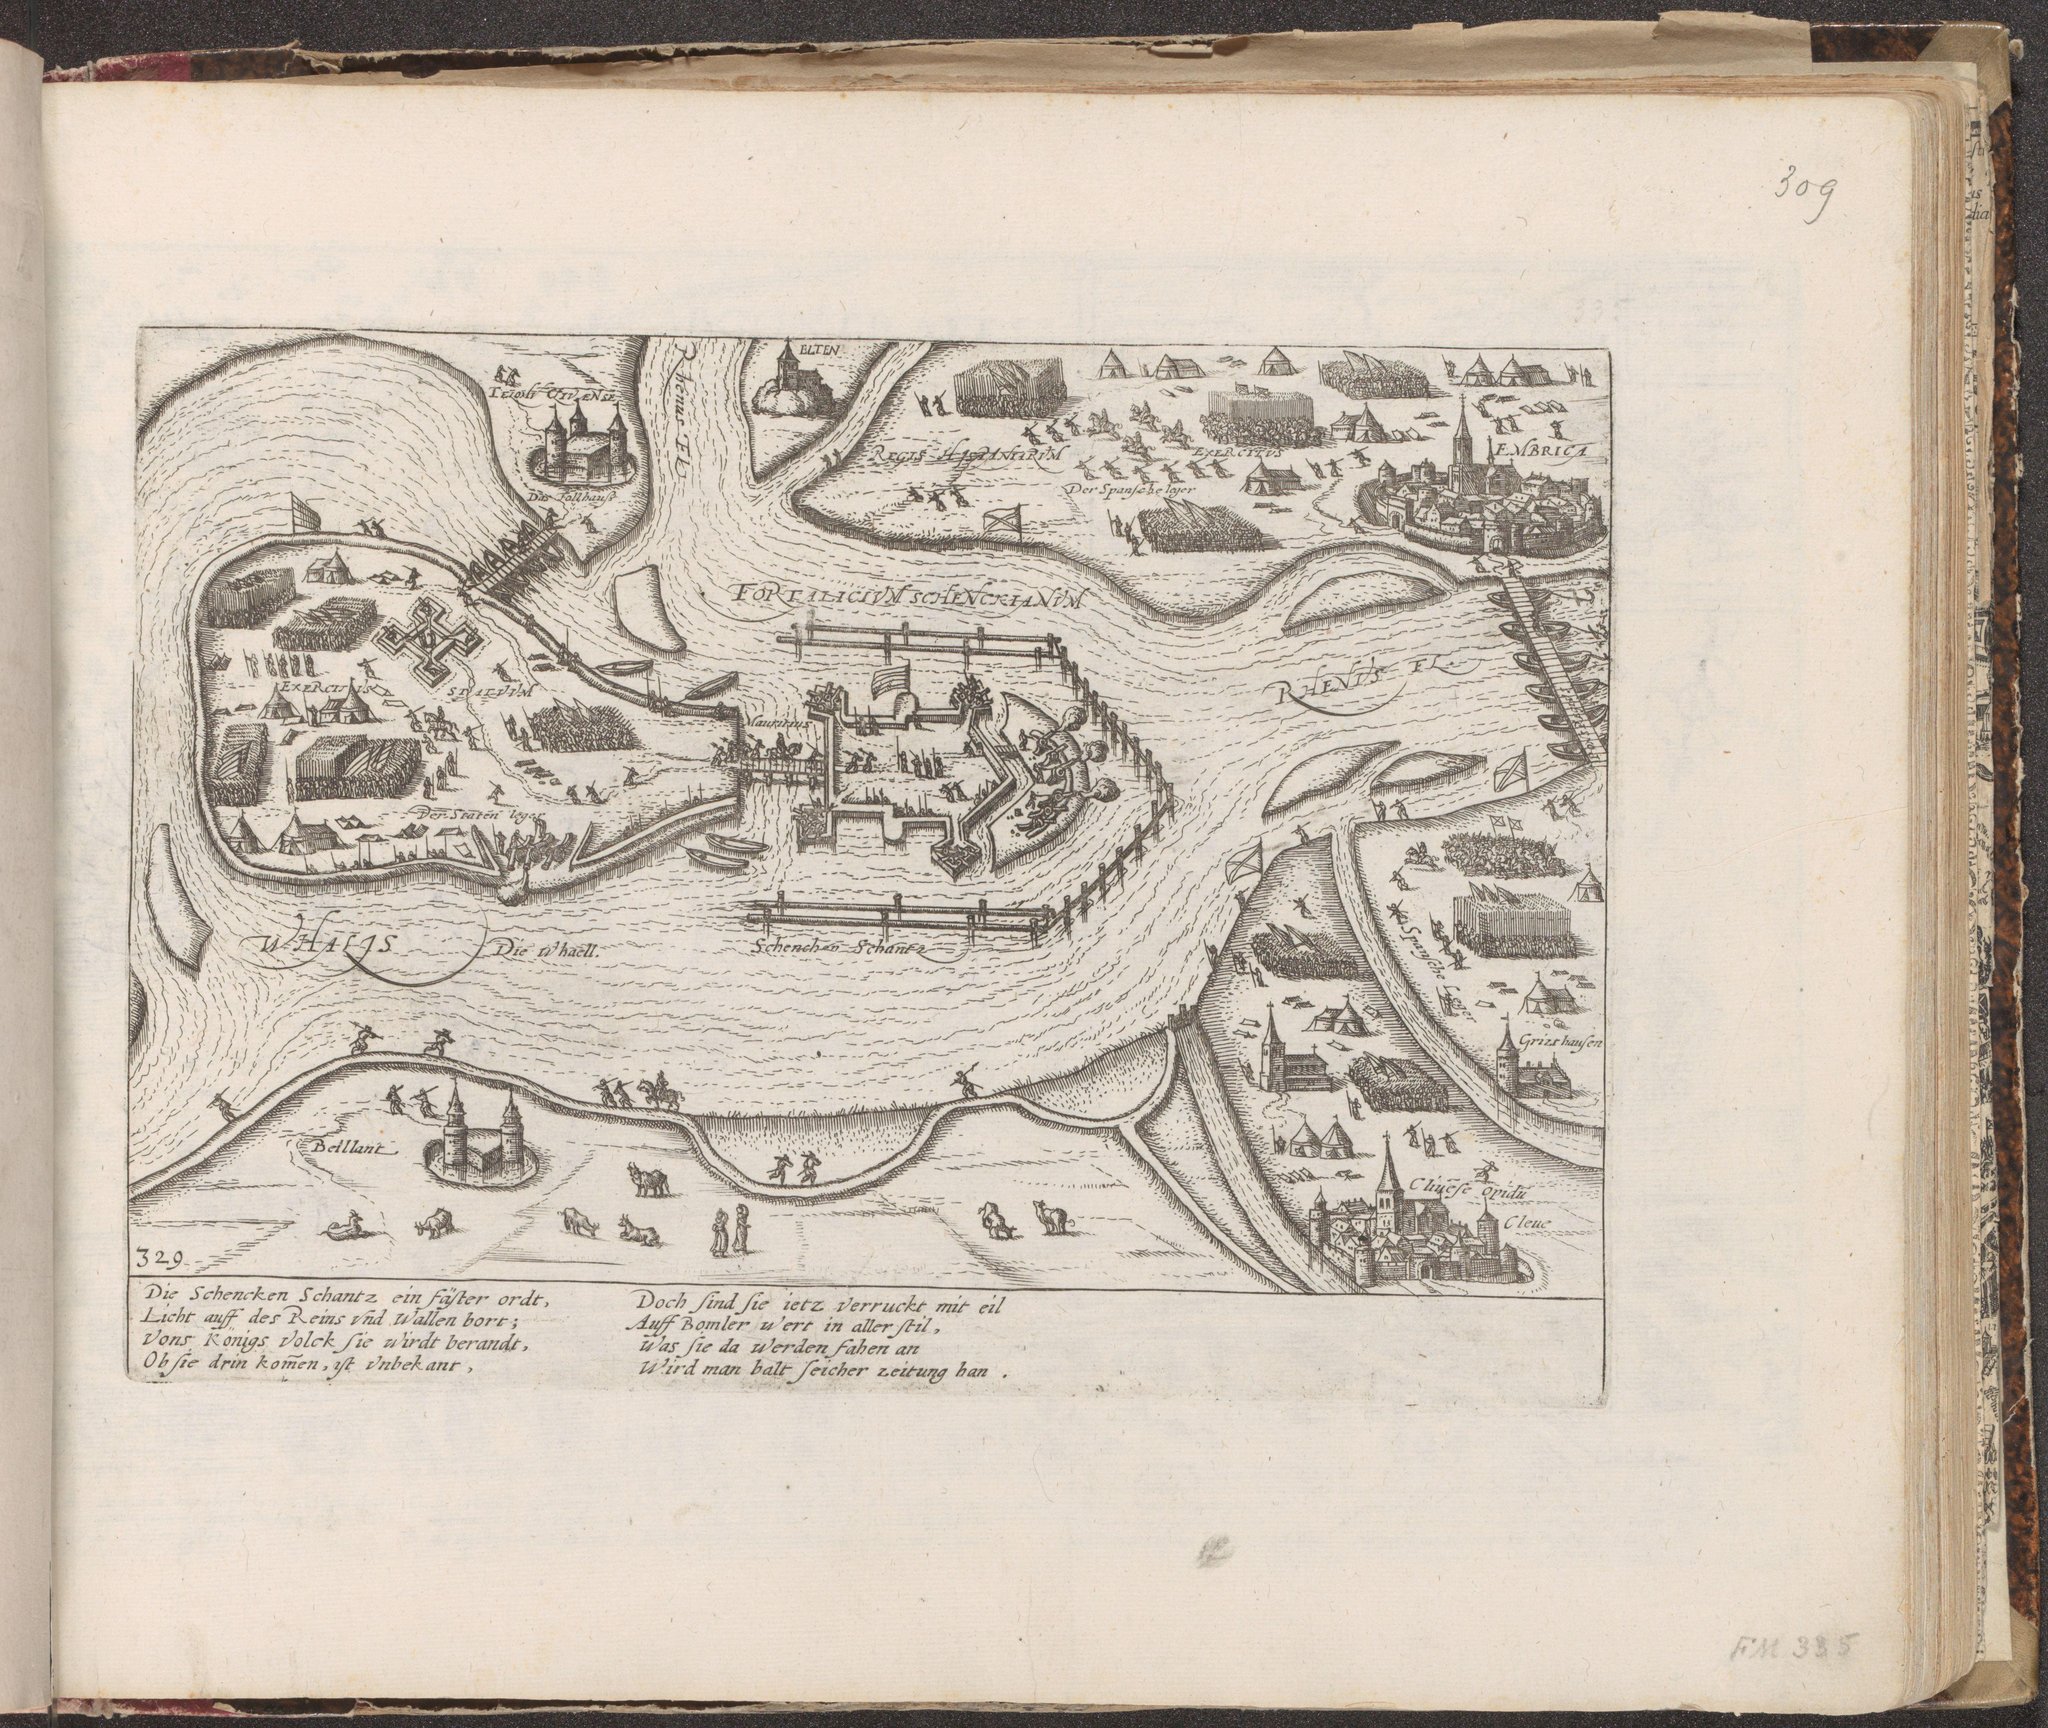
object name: print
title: Serie 10: Nederlandse en Buitenlandse Gebeurtenissen, 1587-1612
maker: frans hogenberg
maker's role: print maker, publisher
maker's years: 1538-1590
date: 1599-1601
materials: paper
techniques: etching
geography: cologne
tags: the hague, maurice (prince of orange), siege, position war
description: Beleg van Schenkenschans op de splitsing van de Rijn en de Waal door de Spanjaarden onder Mendoza, april 1599. Met onderschrift van 16 regels in het Duits. Linksonder genummerd: 329. De prent maakt deel uit van een album.